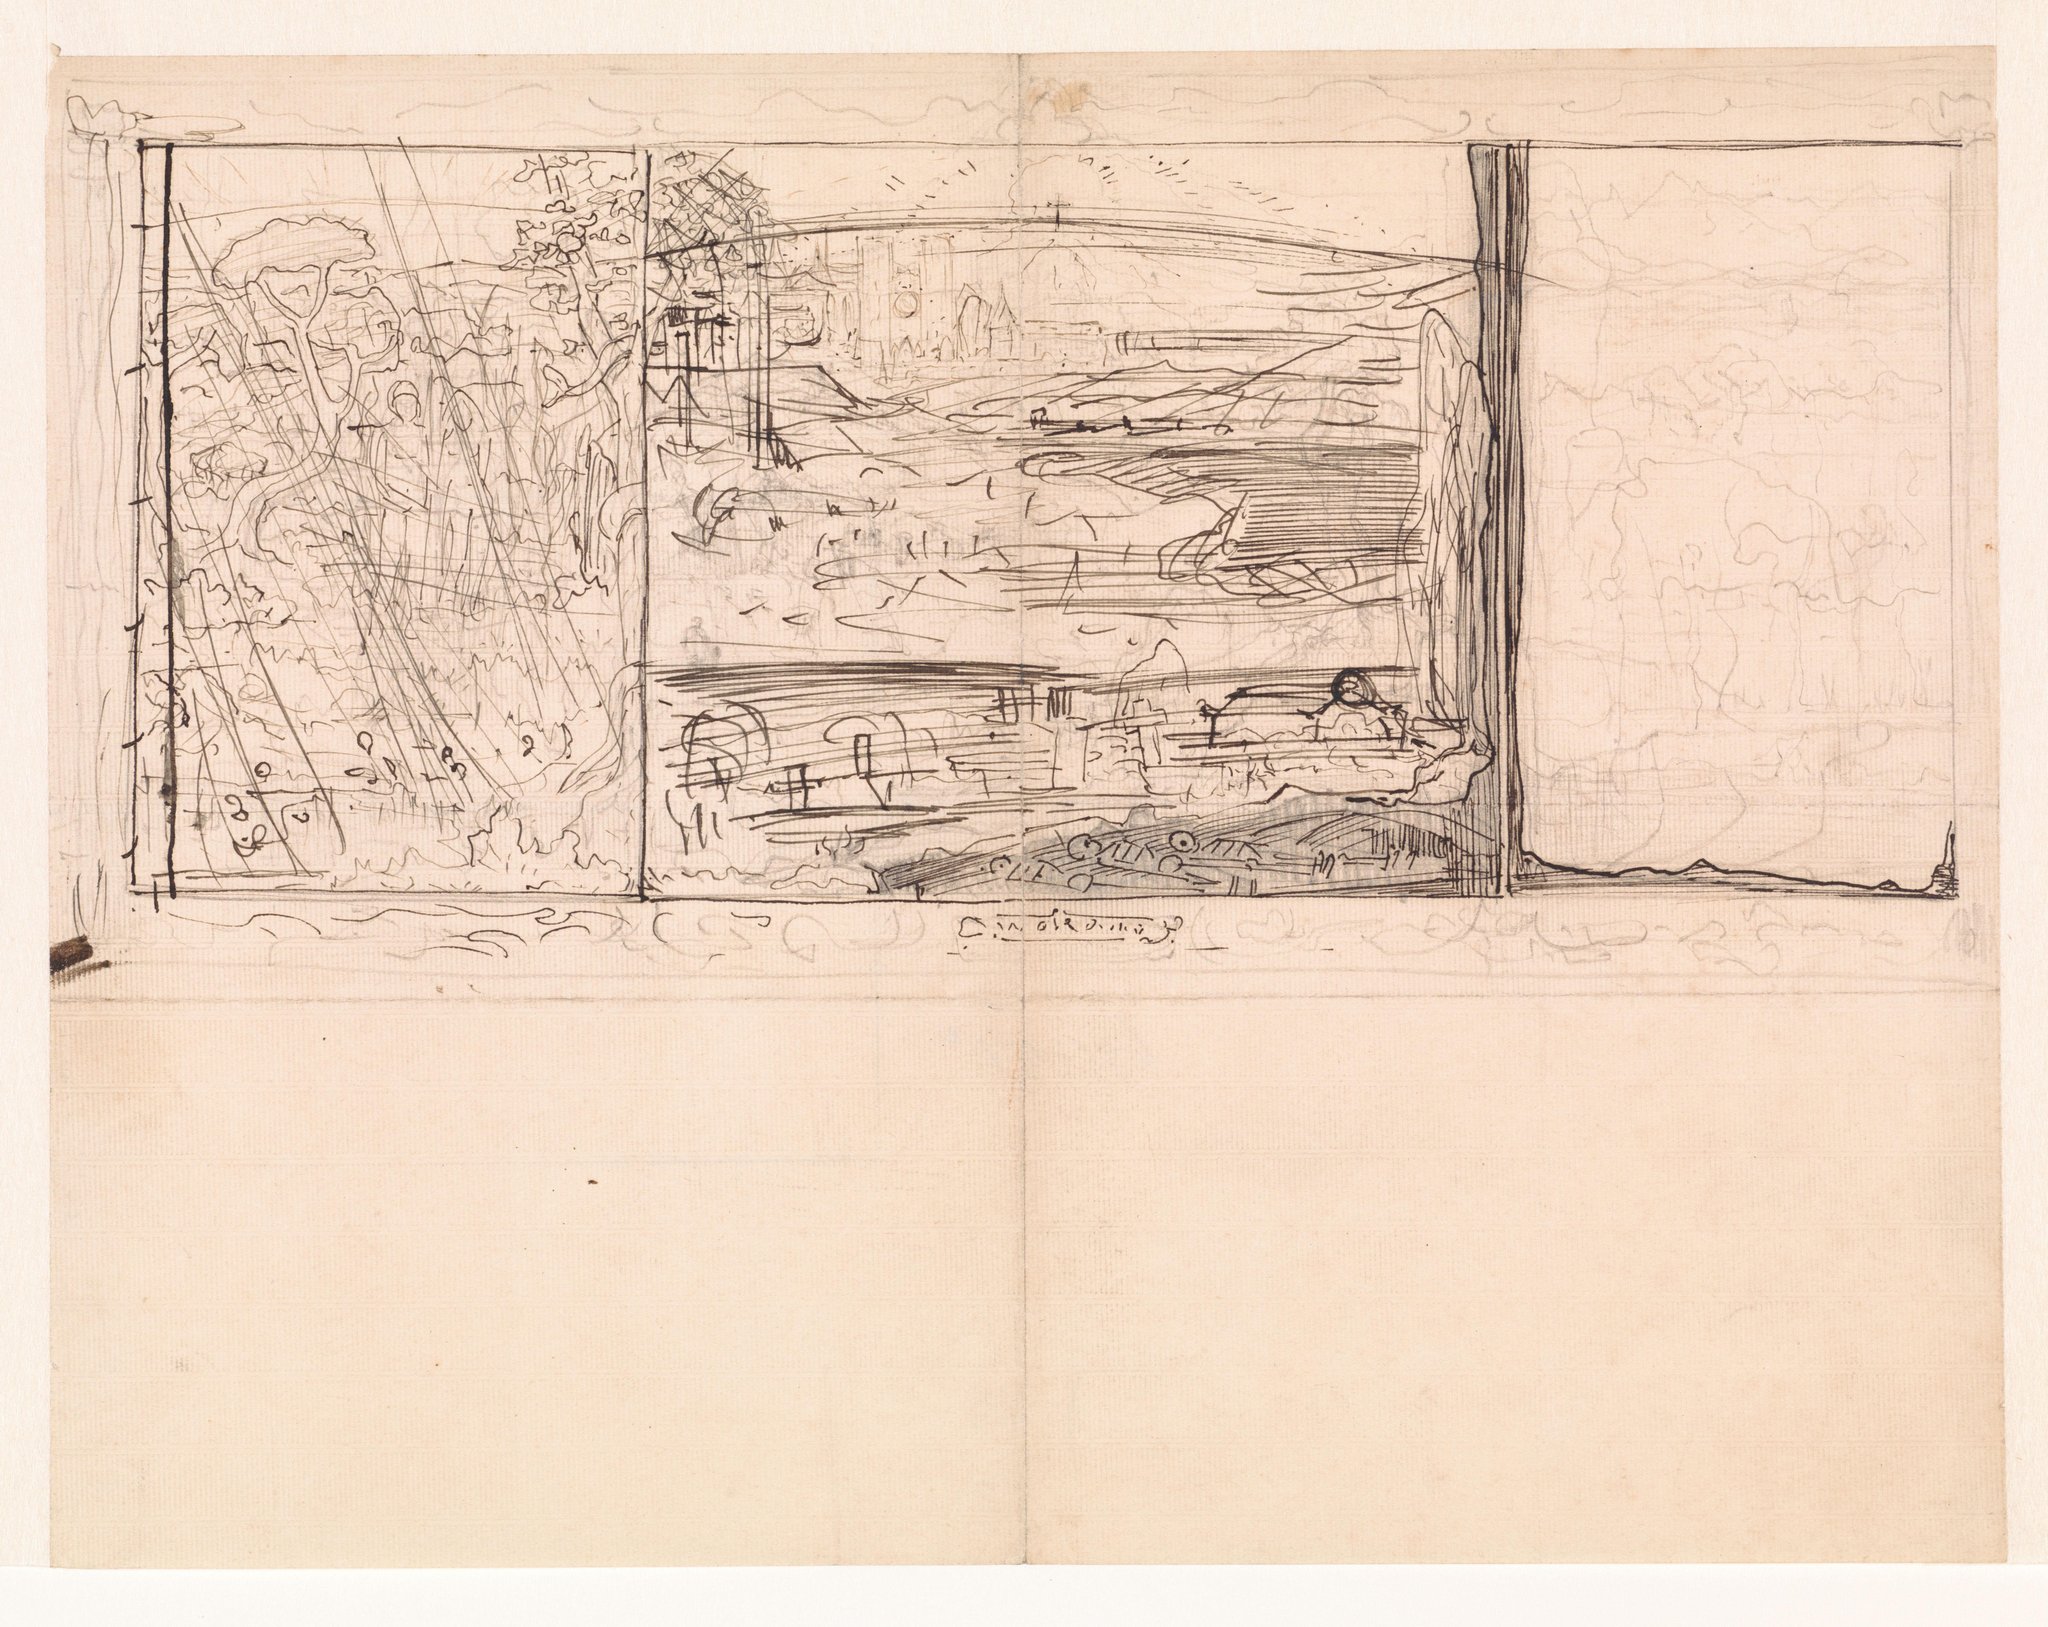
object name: drawing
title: Allegorische voorstelling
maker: edzard koning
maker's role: draughtsman, print maker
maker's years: 1869-1954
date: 1879-1954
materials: ink, paper, pencil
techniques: pen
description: Voorstudie voor allegorische voorstelling op drieluik.